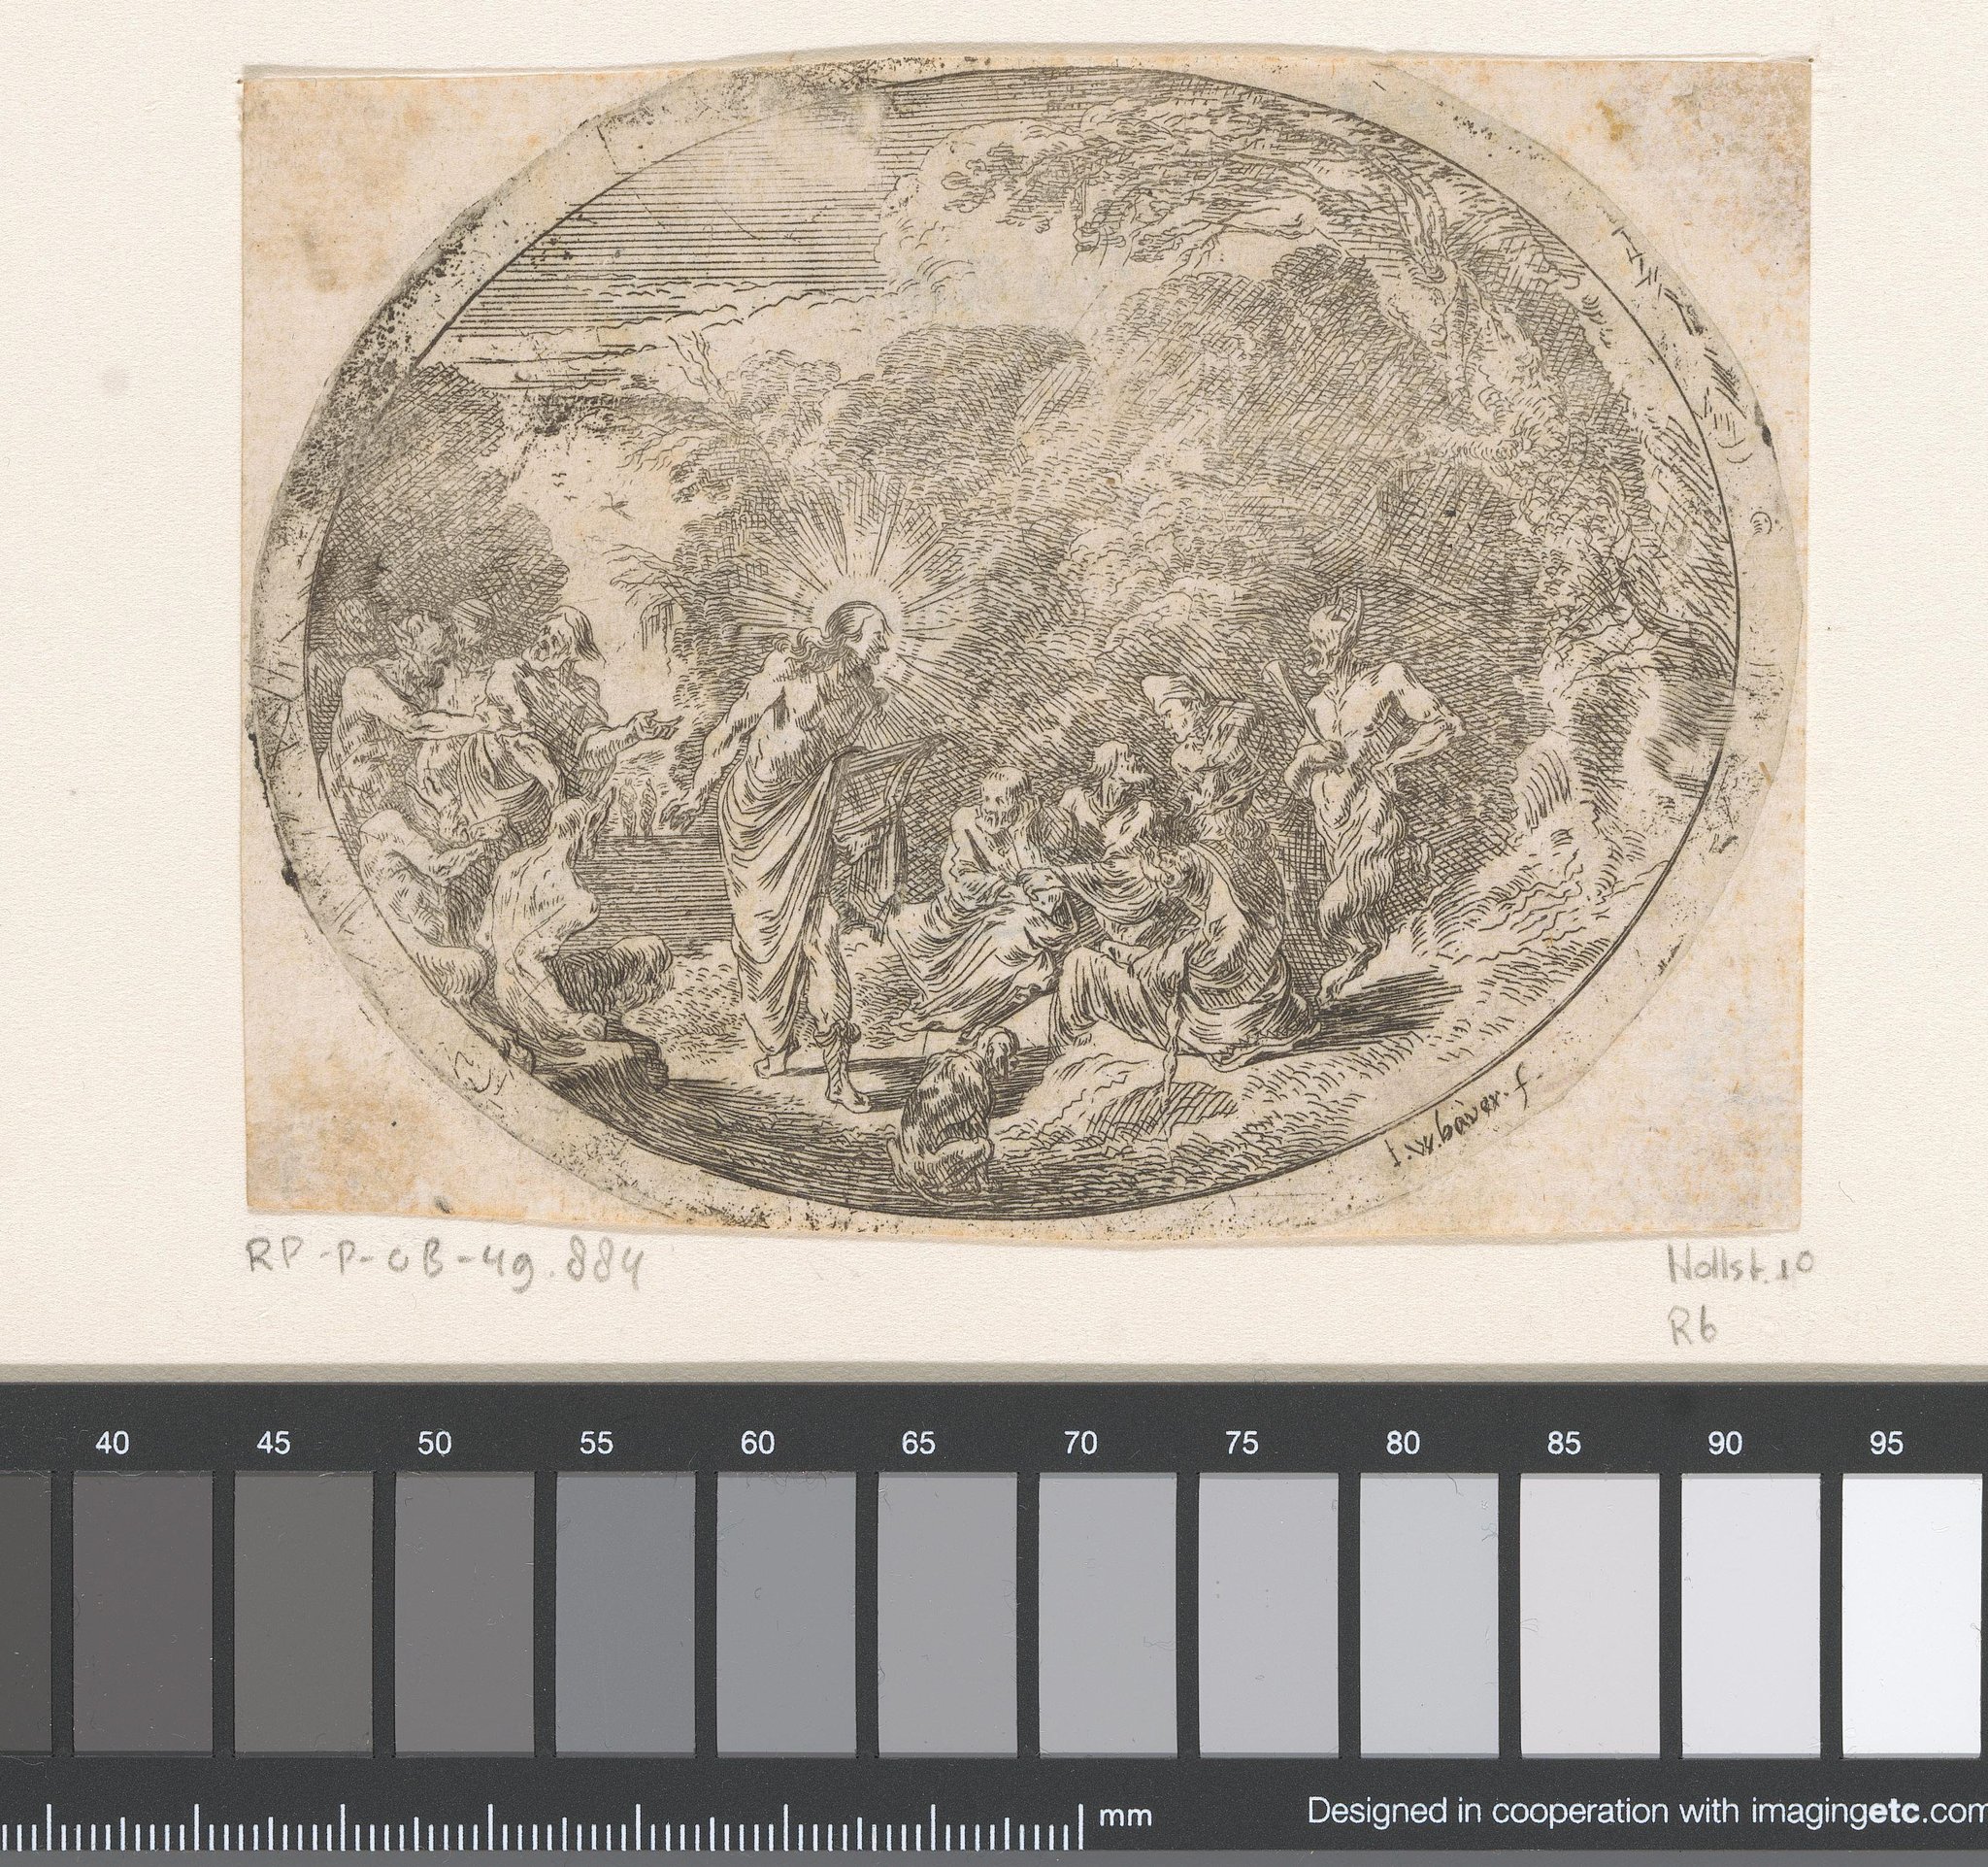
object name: print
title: Oordeel van Midas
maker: johann wilhelm baur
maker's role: draughtsman, painter, print maker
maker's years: 1607-1642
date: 1631-1632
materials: paper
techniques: etching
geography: naples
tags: contest between apollo and pan with the mountain god tmolus as judge, i.e. judgement of midas; midas often represented with ass's ears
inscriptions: collector's mark: Lugt 240, collector's mark: Lugt 2228